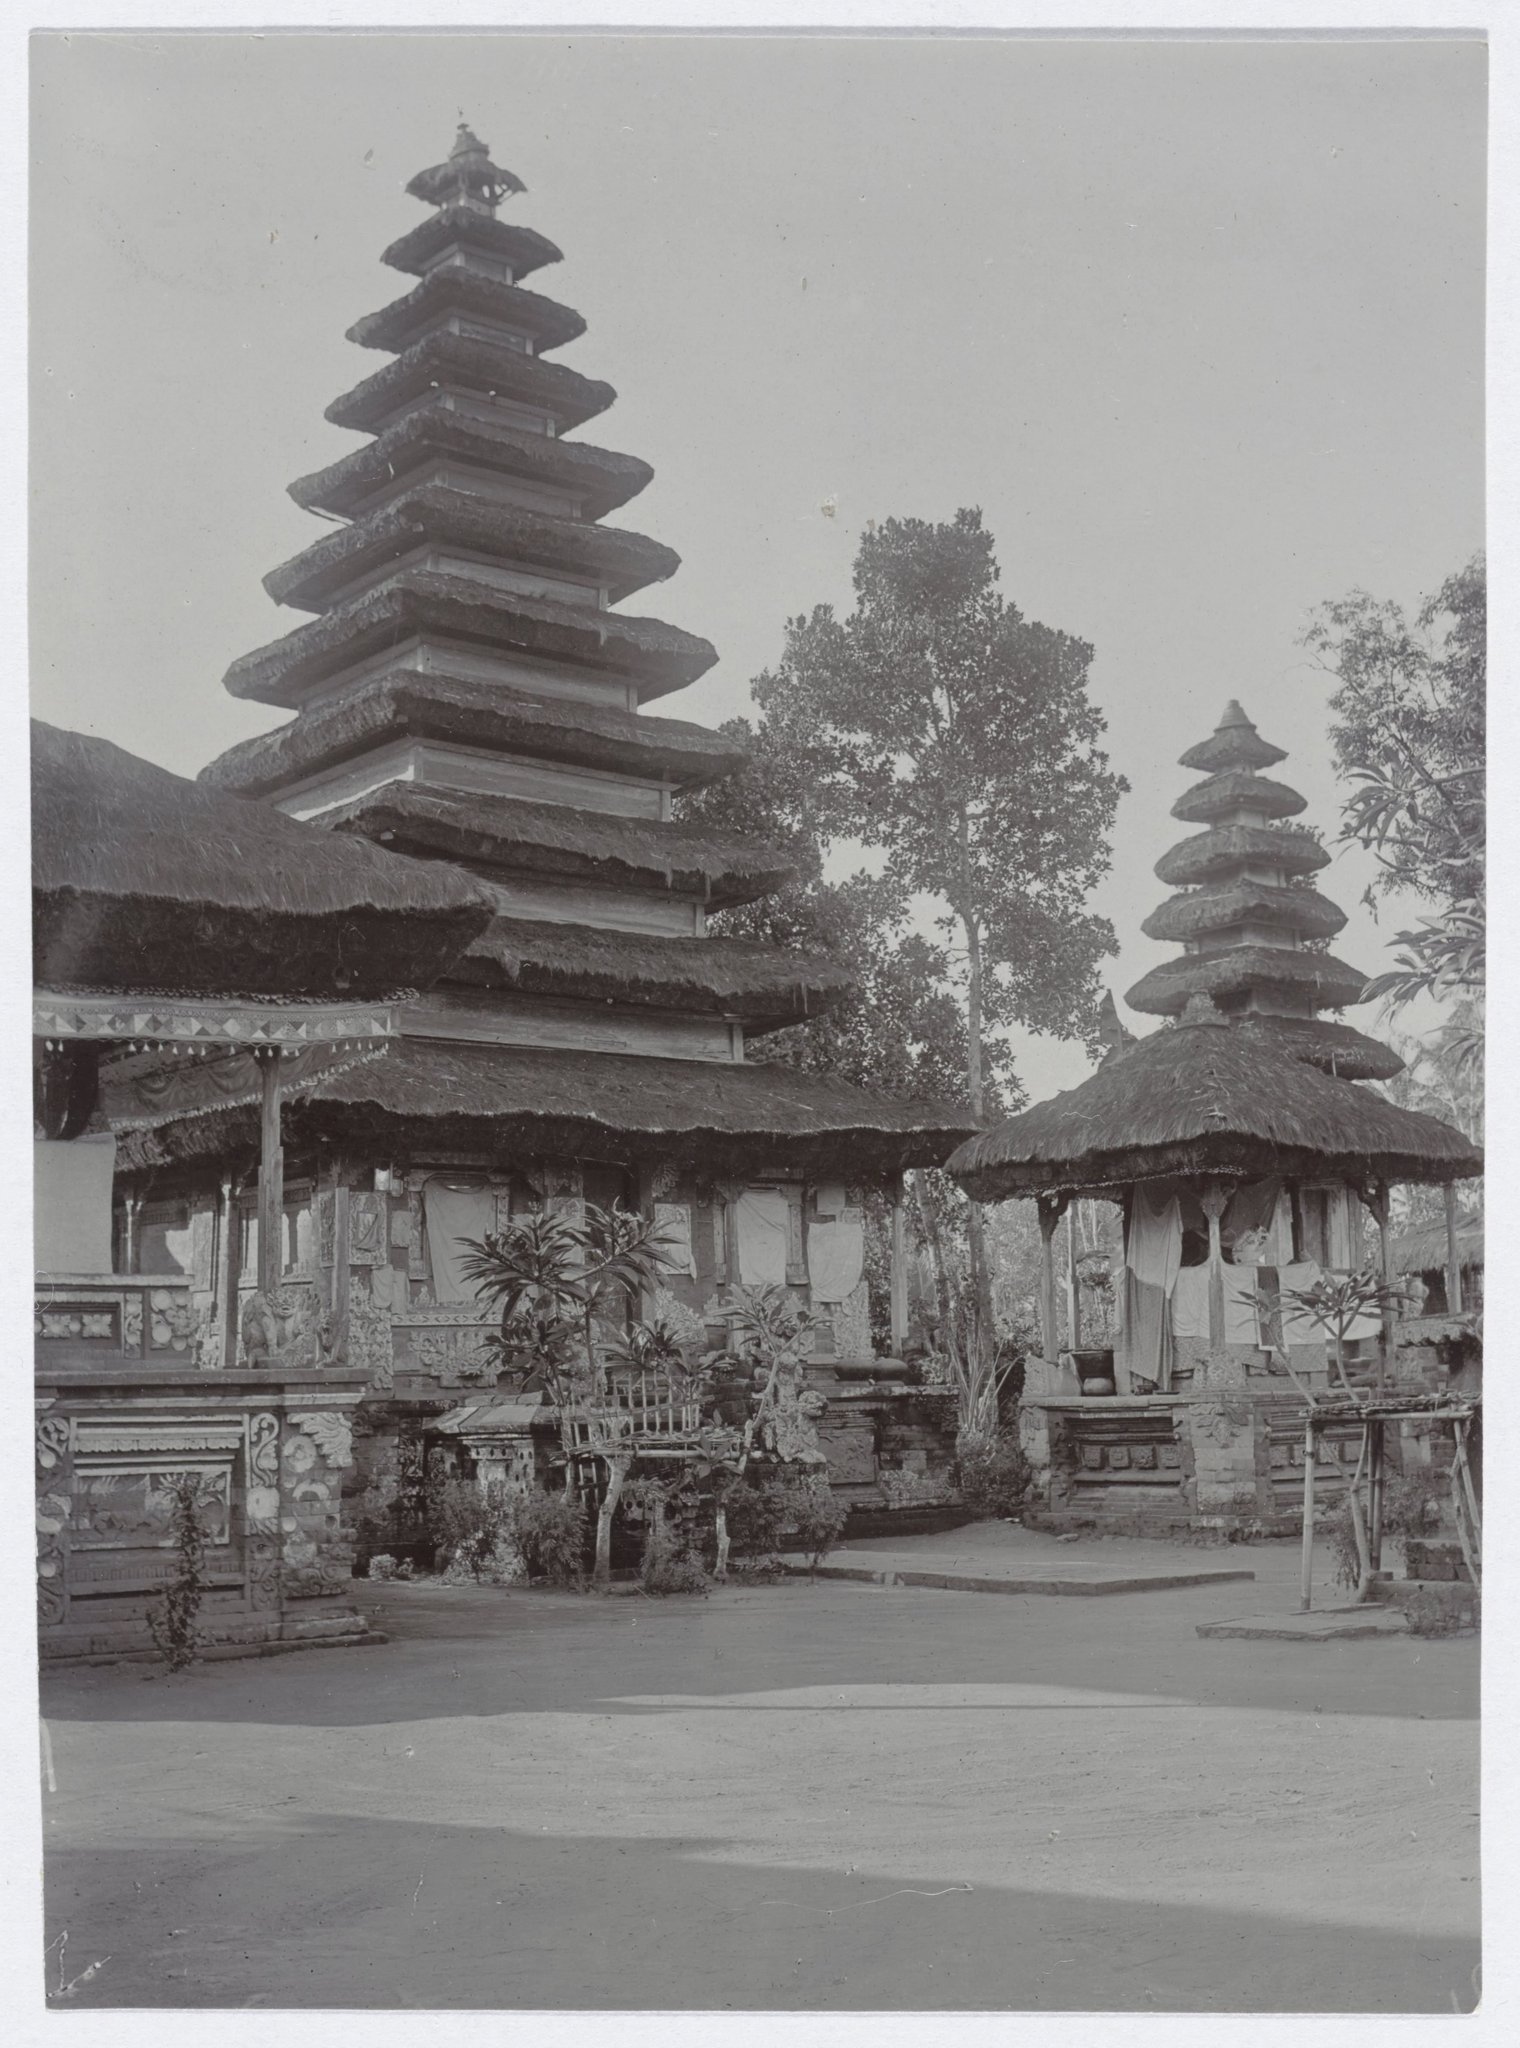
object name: photograph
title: 7. Zuid-Bali. Meroeh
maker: johanna hermina marmelstein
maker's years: 1897-1990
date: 1900-1915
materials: paper, photographic support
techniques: albumen print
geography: jakarta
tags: bali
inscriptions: annotation: ‘7. Zuid-Bali. Meroeh (roemahdewa = godenhuis) met 11 afdaken van idjoek bij kloengkaeng. Deze meroeh's mocht alleen door de allerhoogste priester 1 a 2 malen 's jaars bij zeer belangrijke feesten betreden worden. Niemand anders mocht deze heiligdommen binnentreden.’